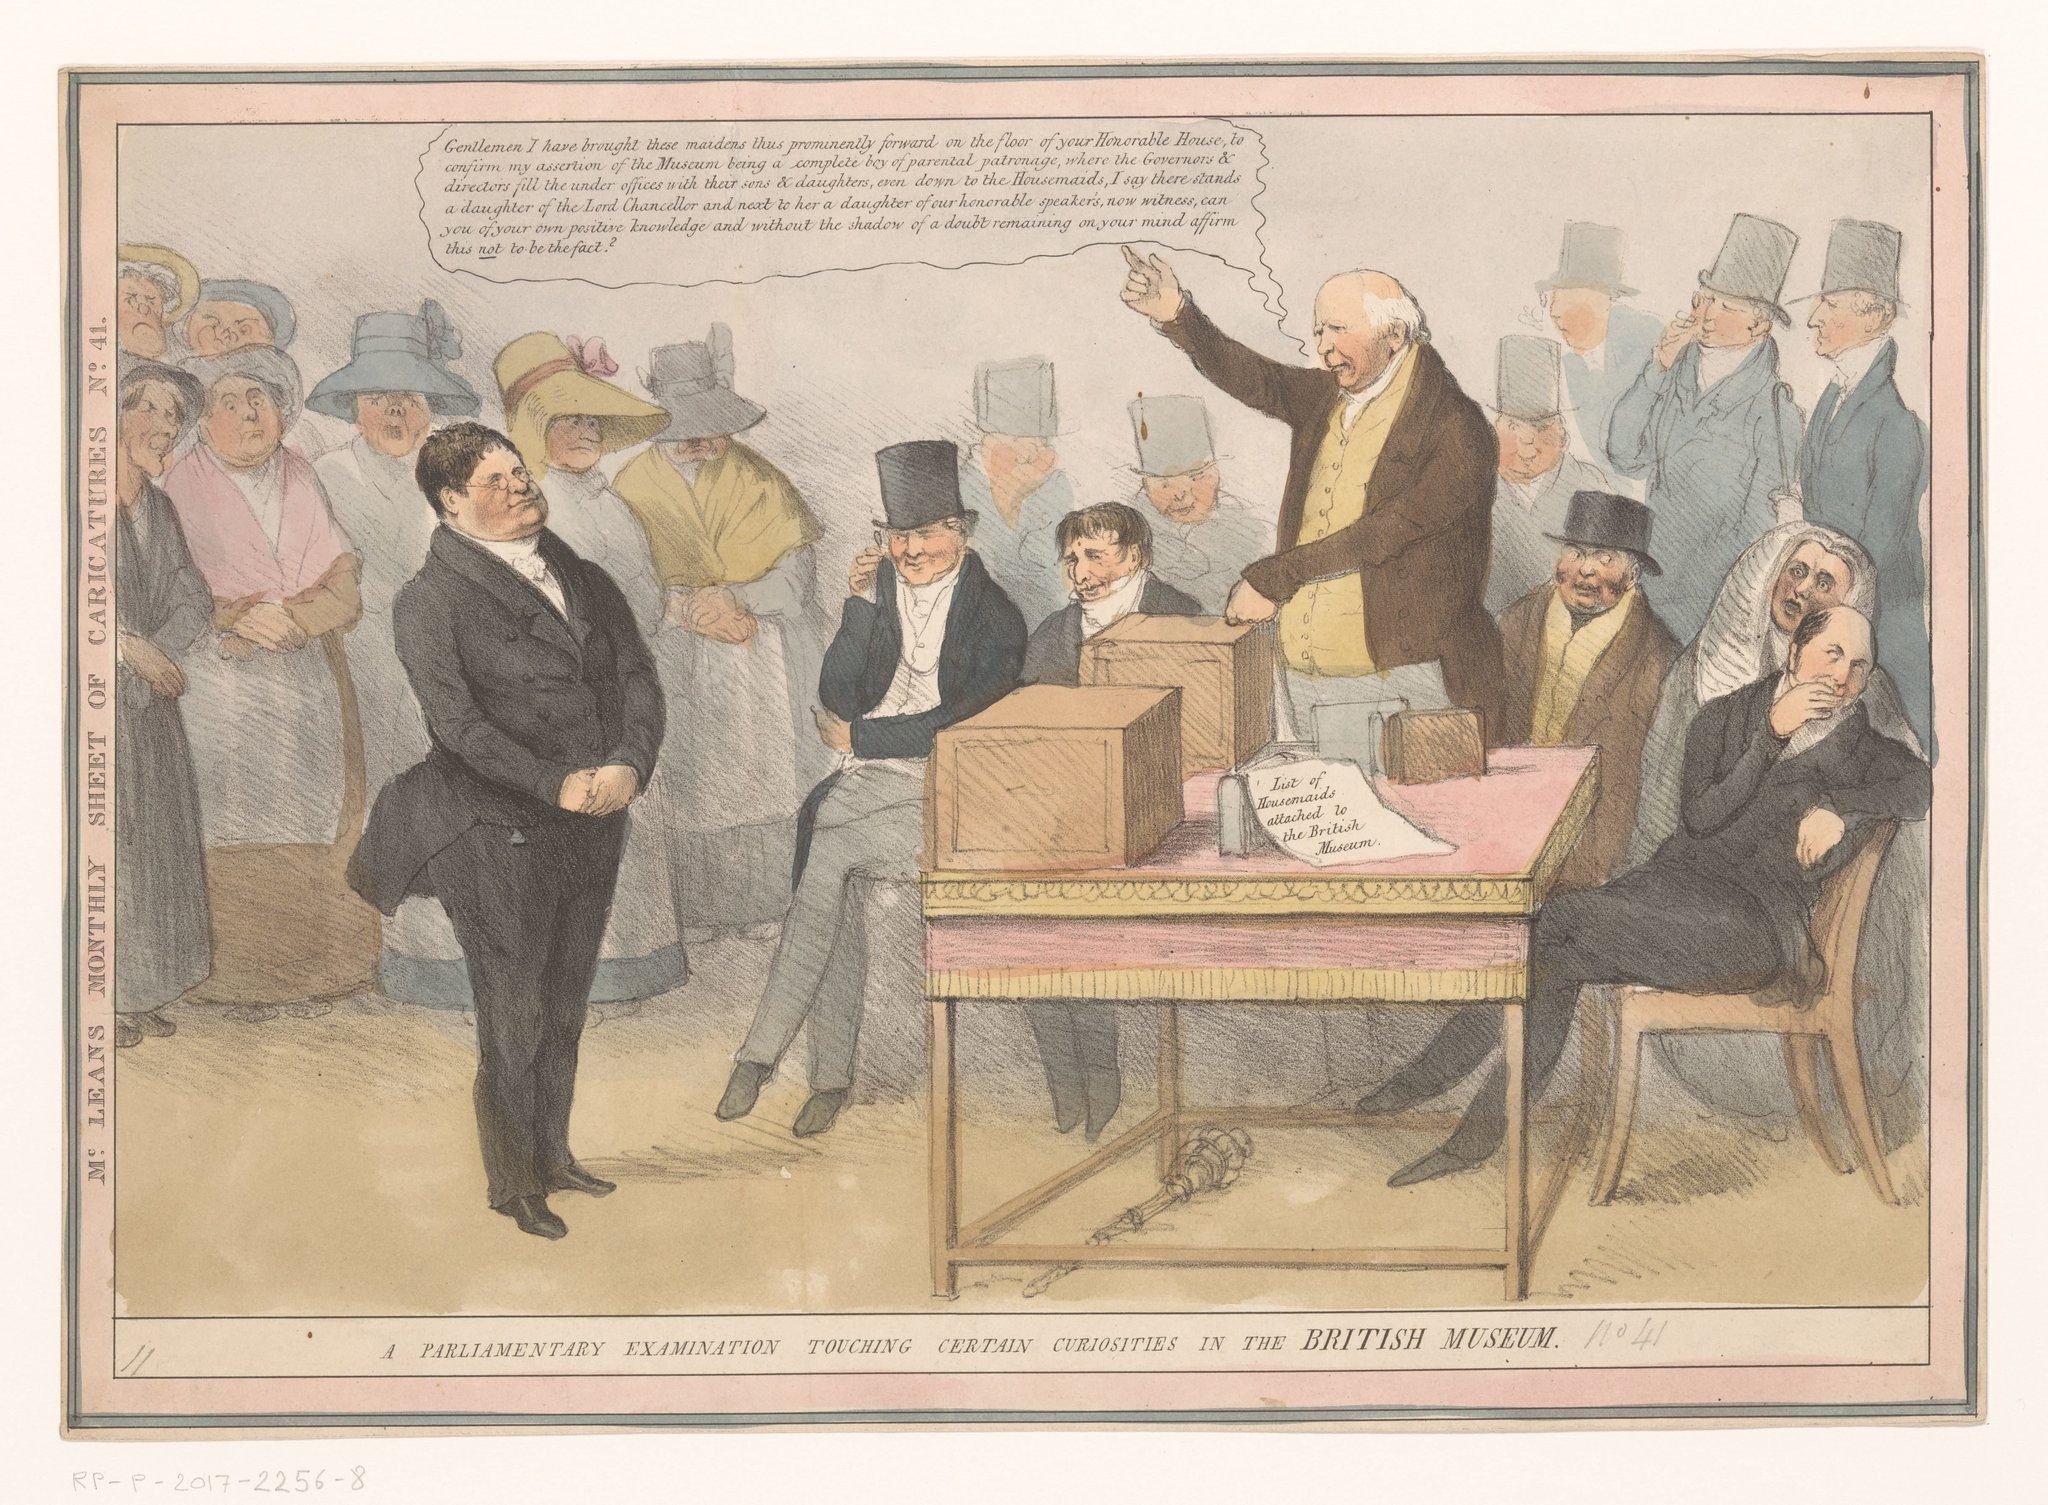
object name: print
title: Spotprent over de British Museum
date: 1806-1833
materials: paper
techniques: hand coloring, lithograph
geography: england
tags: lower house, parliament, chamber, committee members, board members, political caricatures and satires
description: Spotprent waarin de Sir Henry Ellis, hoofdbibliothecaris van de British Museum door een parlementaire commissie onder William Cobbett beschuldigd wordt van nepotisme, juni 1833.